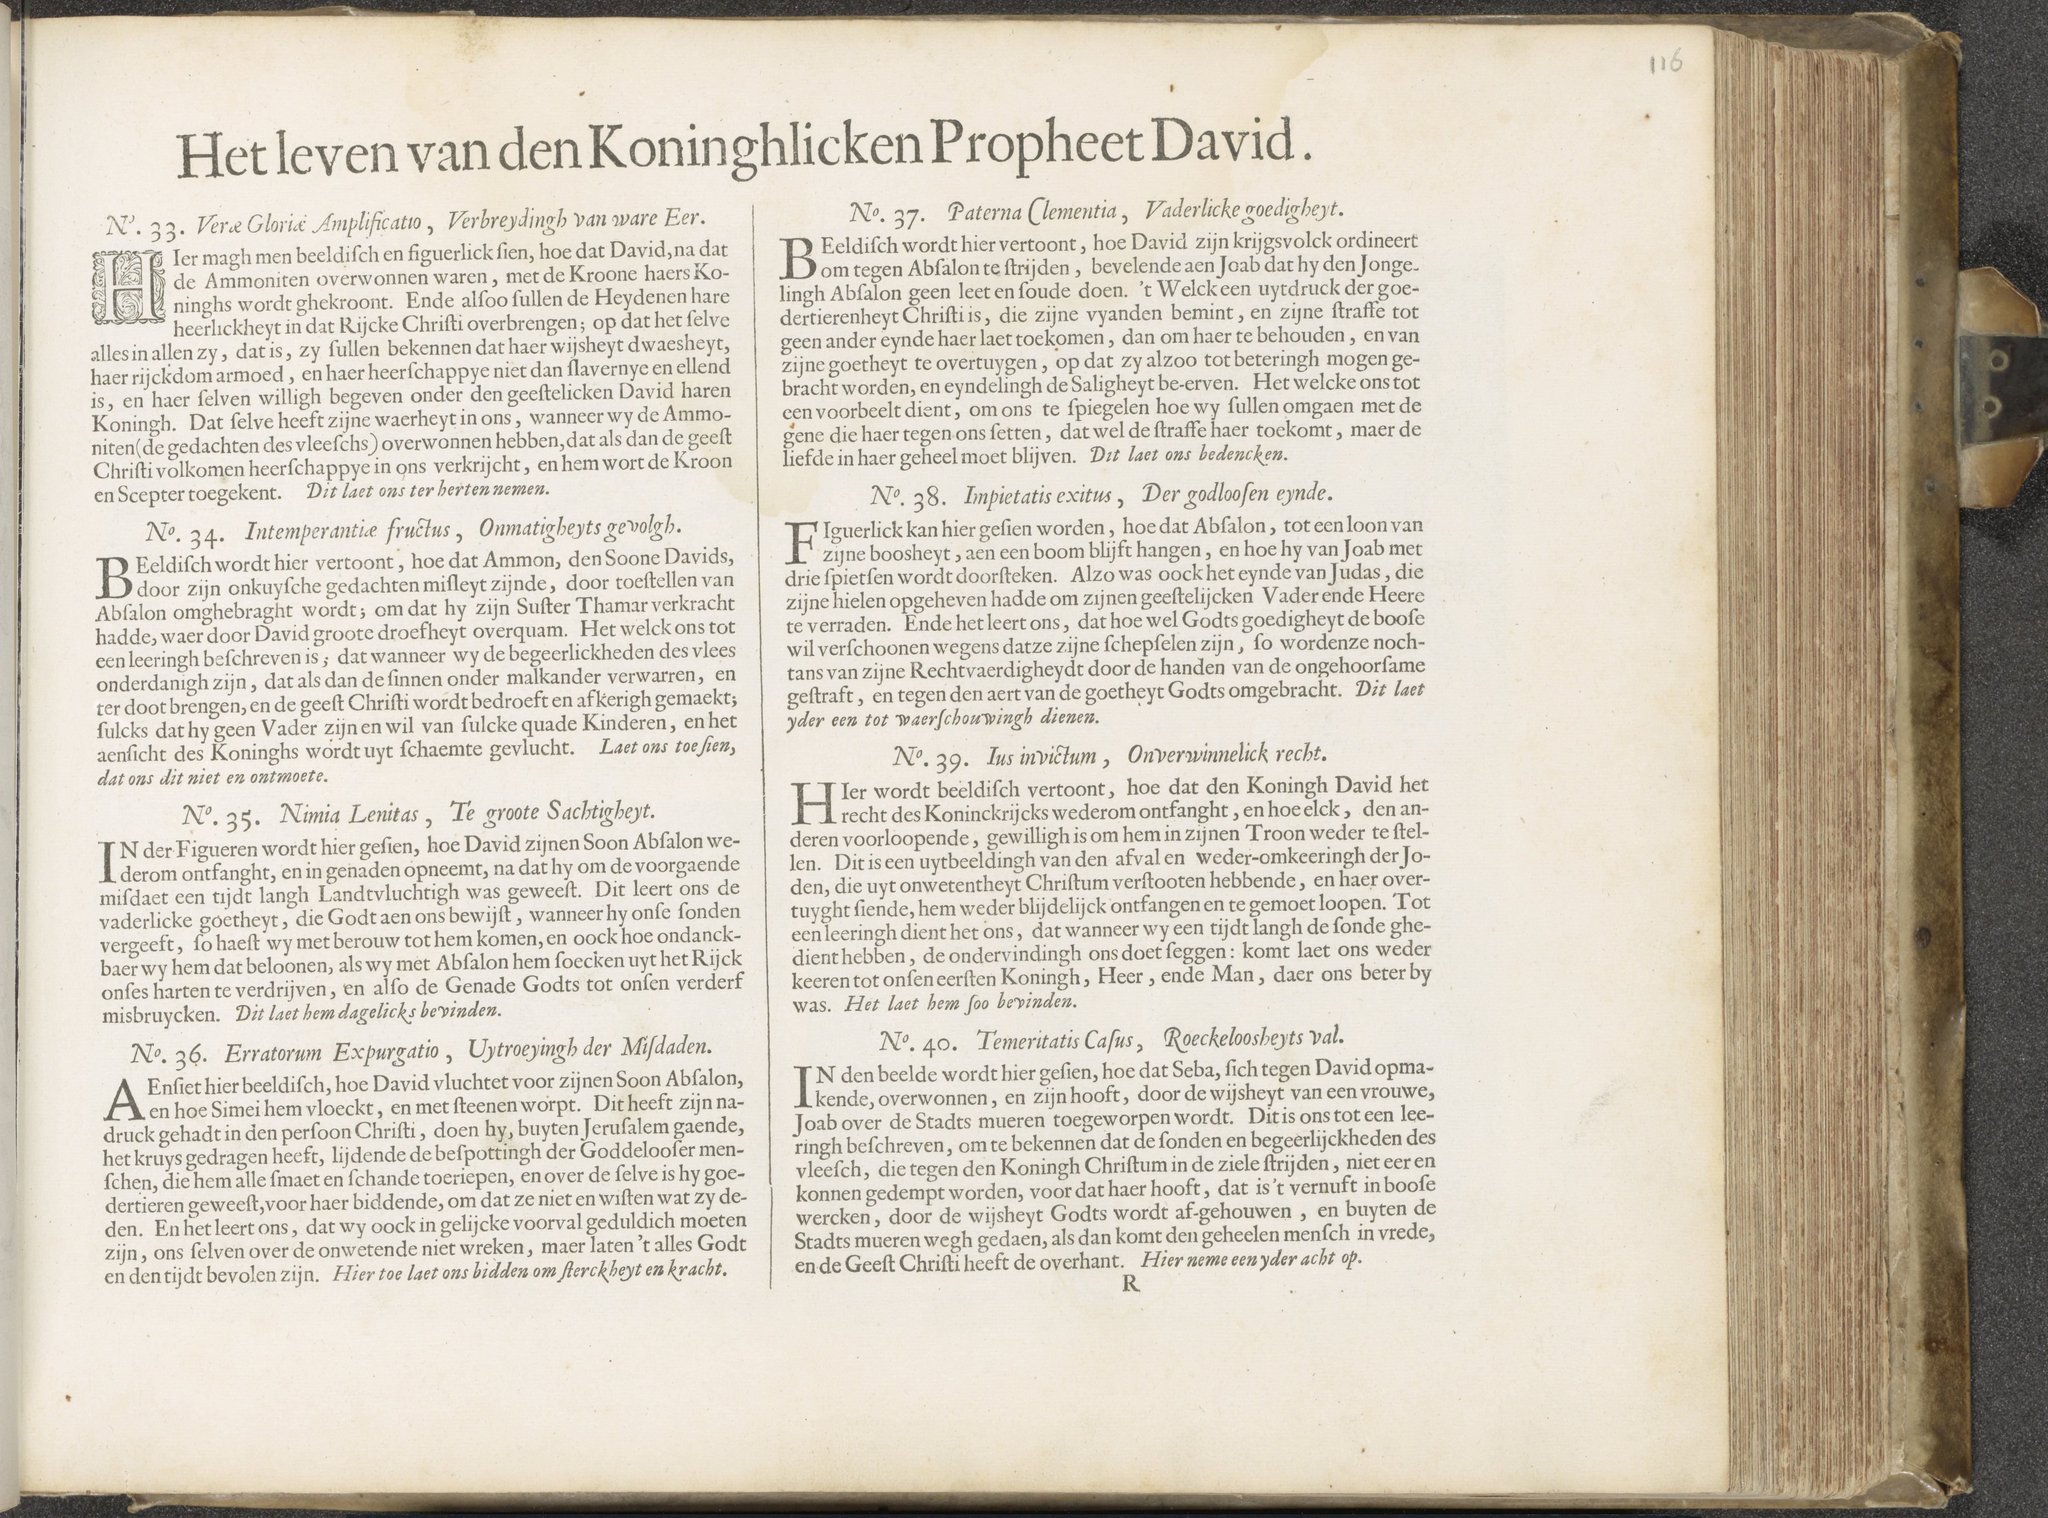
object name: text sheet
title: Den Grooten Emblemata Sacra, bestaande in meer dan vier hondert bybelsche figuren, zoo des Ouden als des Nieuwen Testaments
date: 1653-1654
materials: paper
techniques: letterpress printing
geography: amsterdam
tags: initial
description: Acht toelichtingen bij voorstellingen over het leven van David, genummerd 33 tot en met 40. De tekst vangt aan met een kleine gedecoreerde initiaal H. Het blad maakt deel uit van een album.